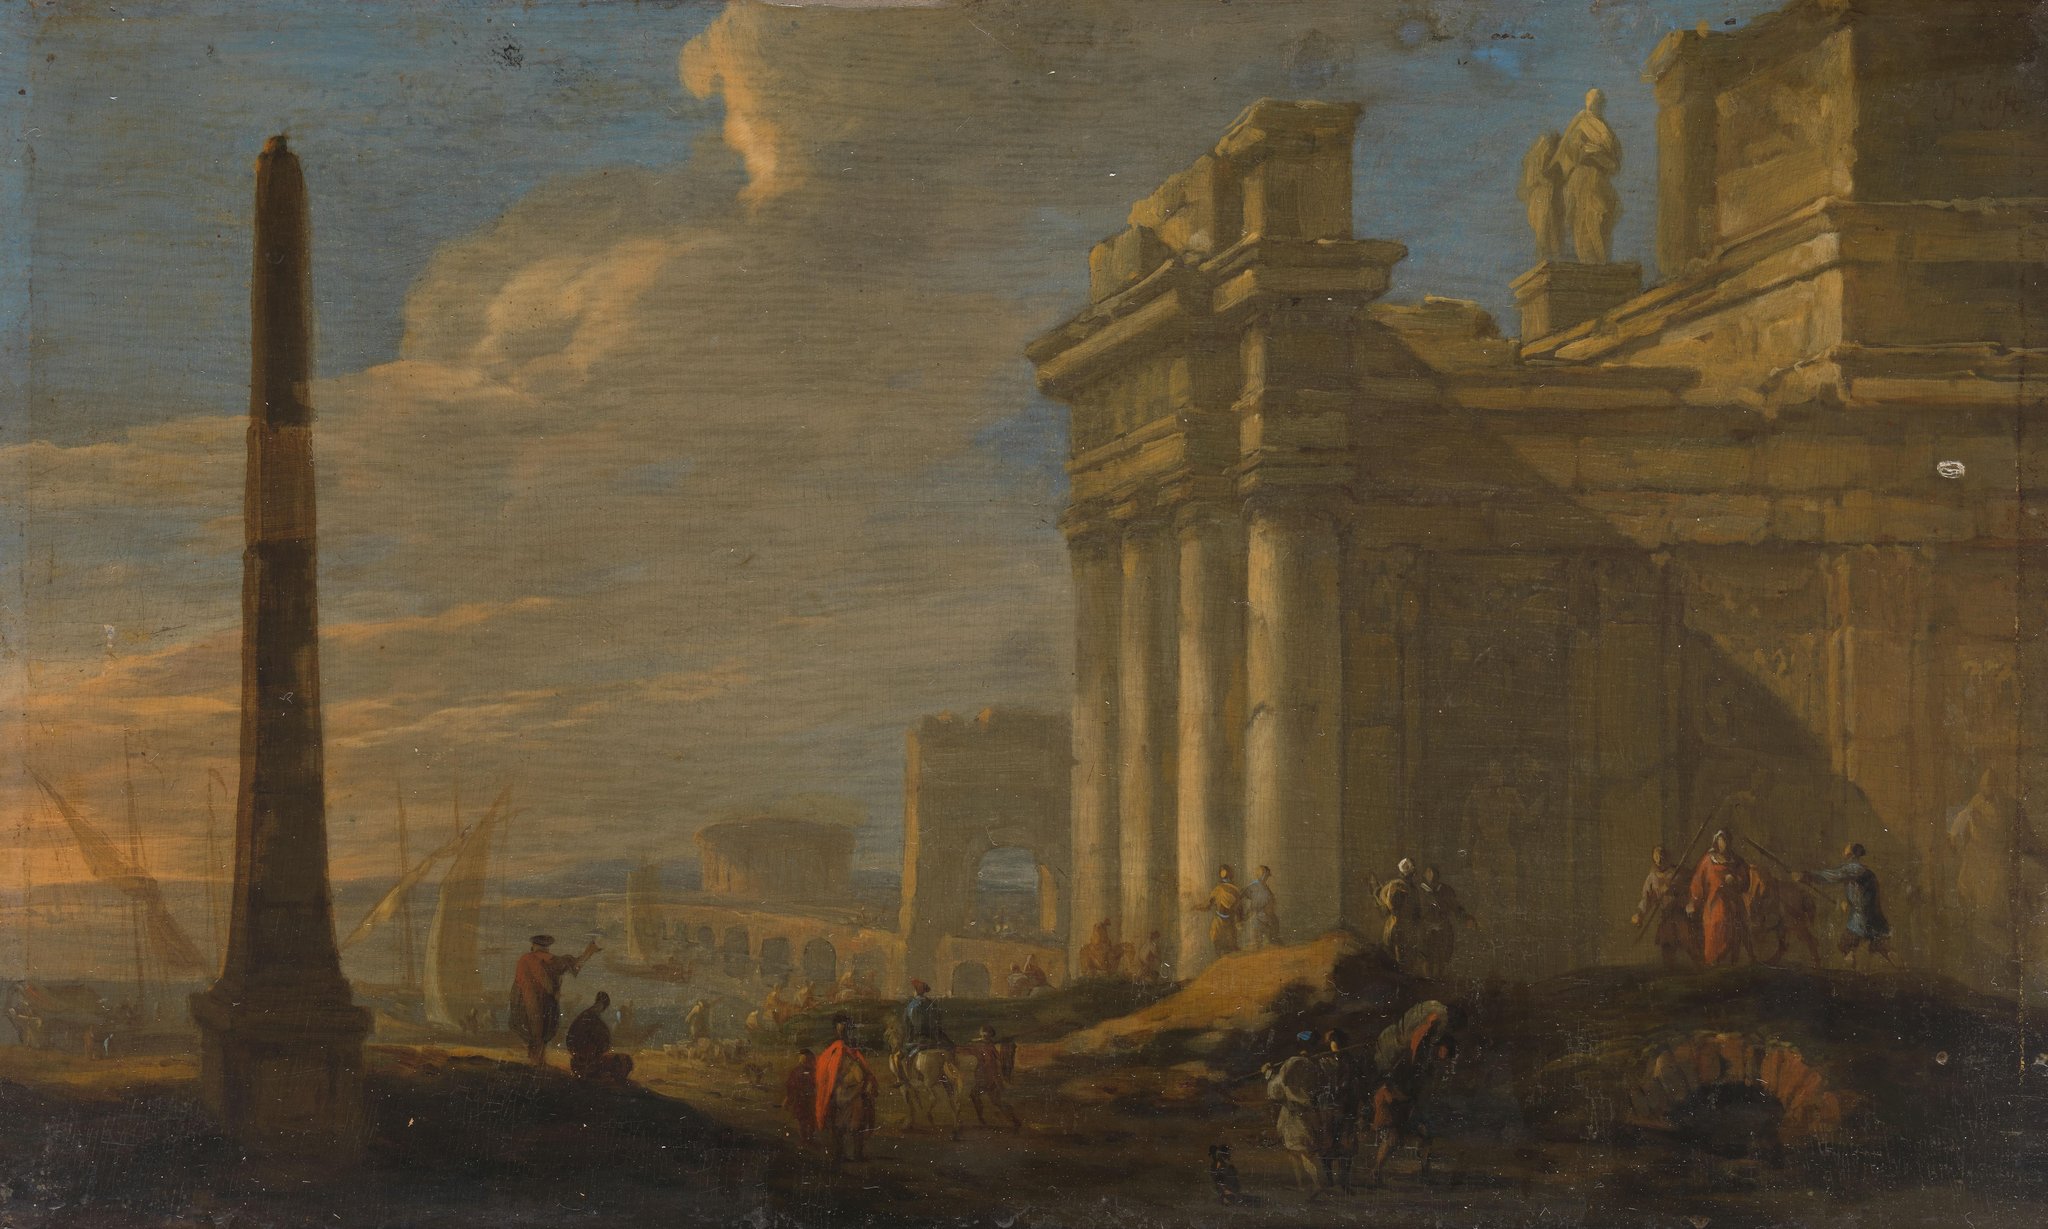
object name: painting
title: Italian harbor view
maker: jacob van der ulft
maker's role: draughtsman, painter, print maker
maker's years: 1627-1689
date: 1650-1689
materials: oil, panel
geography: northern netherlands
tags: harbour, obelisk, needle, ruin of a building ~ architecture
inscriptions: signature: ‘J.v. Ulft’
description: Gezicht in een Italiaanse haven met links een obelisk en rechts ruïnes van een Romeinse tempel en een brug. Tussen de gebouwen lopen allerlei figuren. Pendant van SK-A-420.